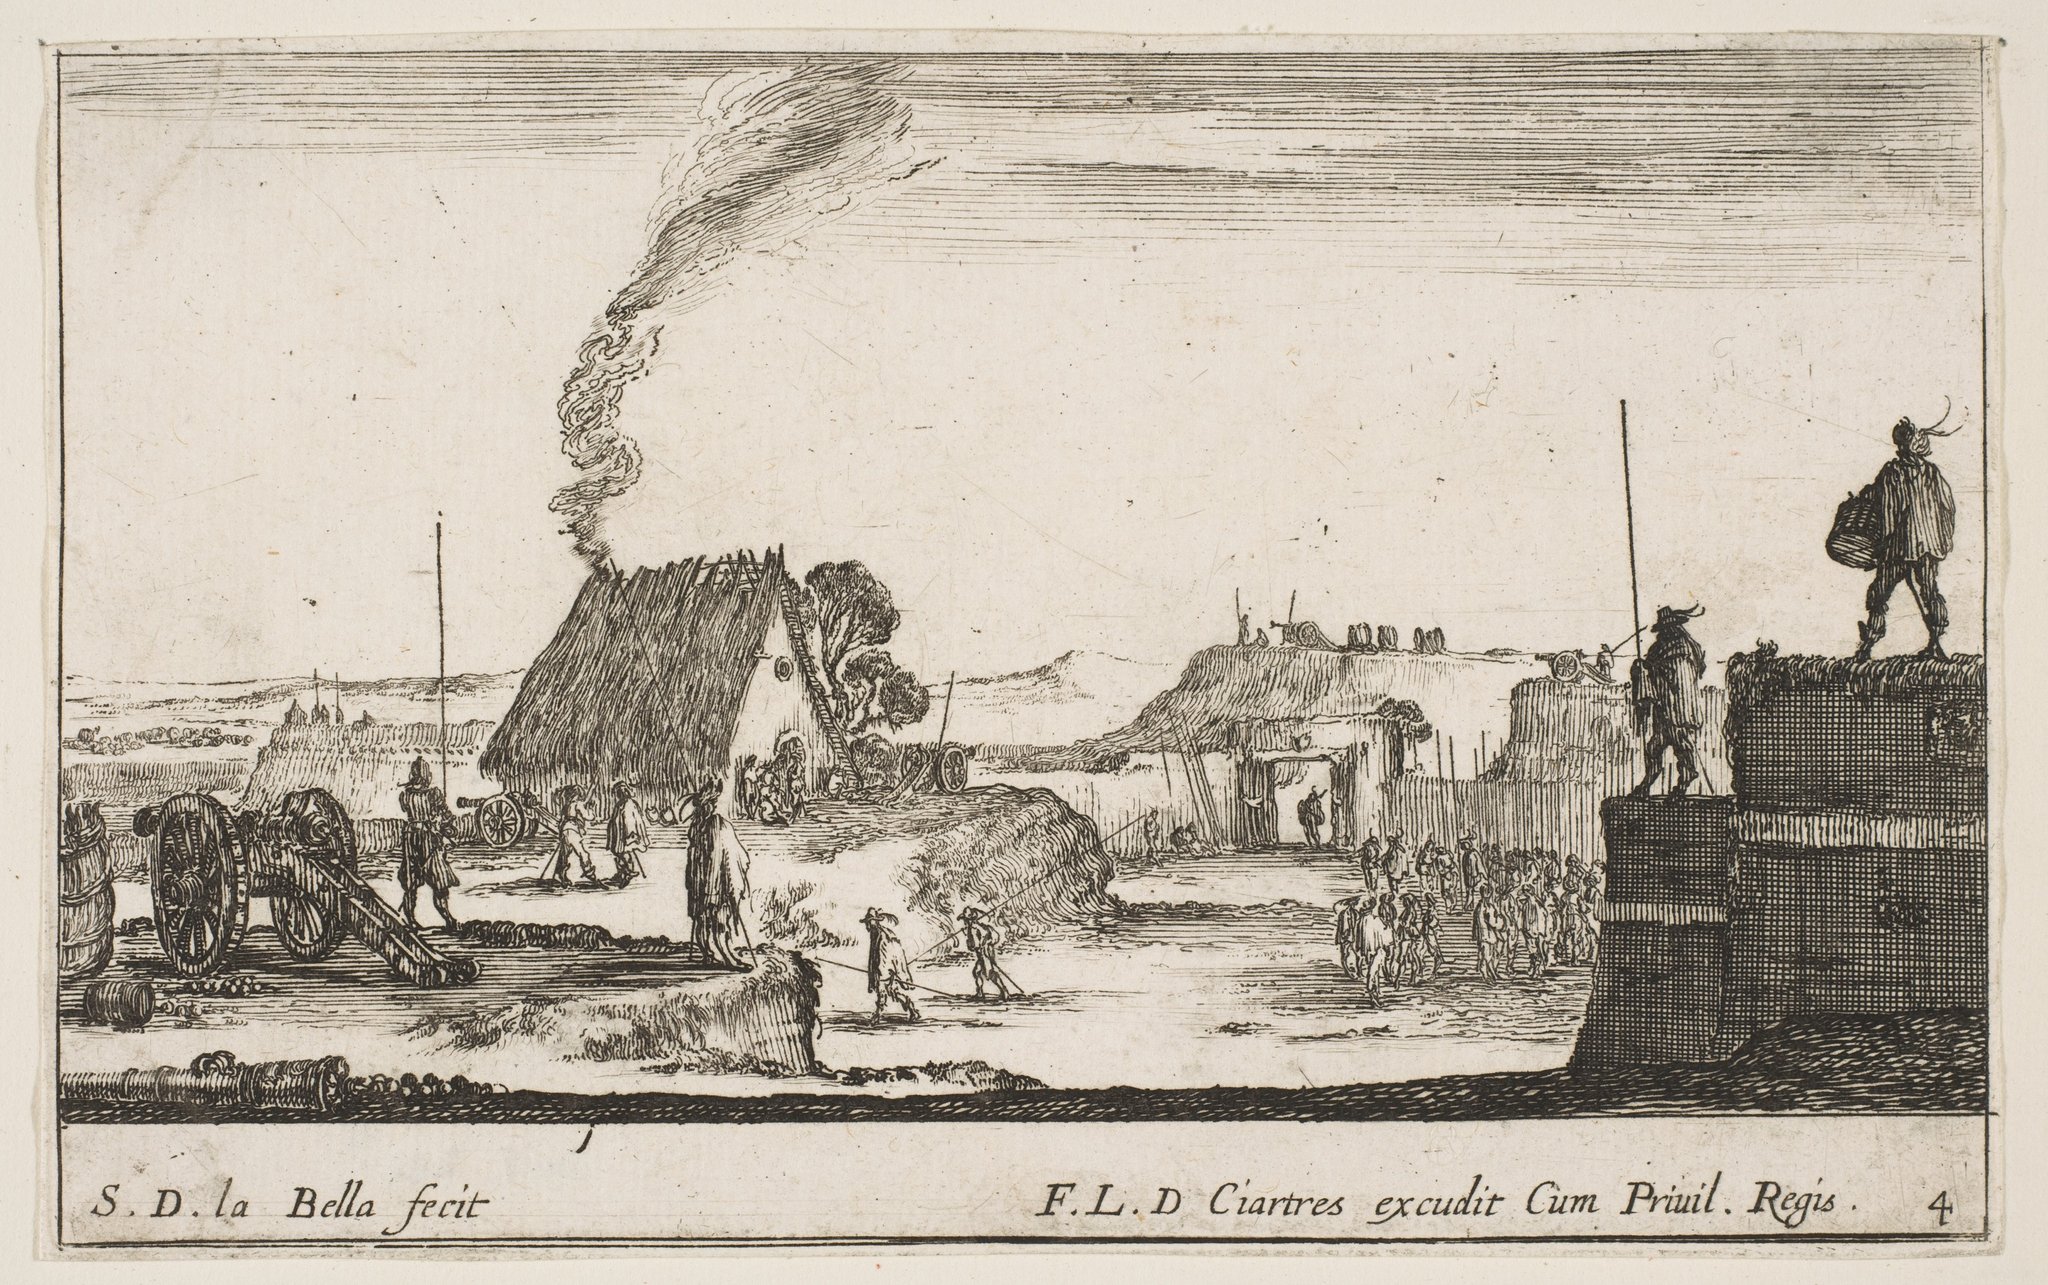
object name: print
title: A military encampment with a soldier standing on a parapet to the right beating a drum, plate 4 from "Various Military Caprices" (Varii capricci militari)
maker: stefano della bella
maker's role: artist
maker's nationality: italian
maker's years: 1610-1664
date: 1641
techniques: etching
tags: soldiers,men